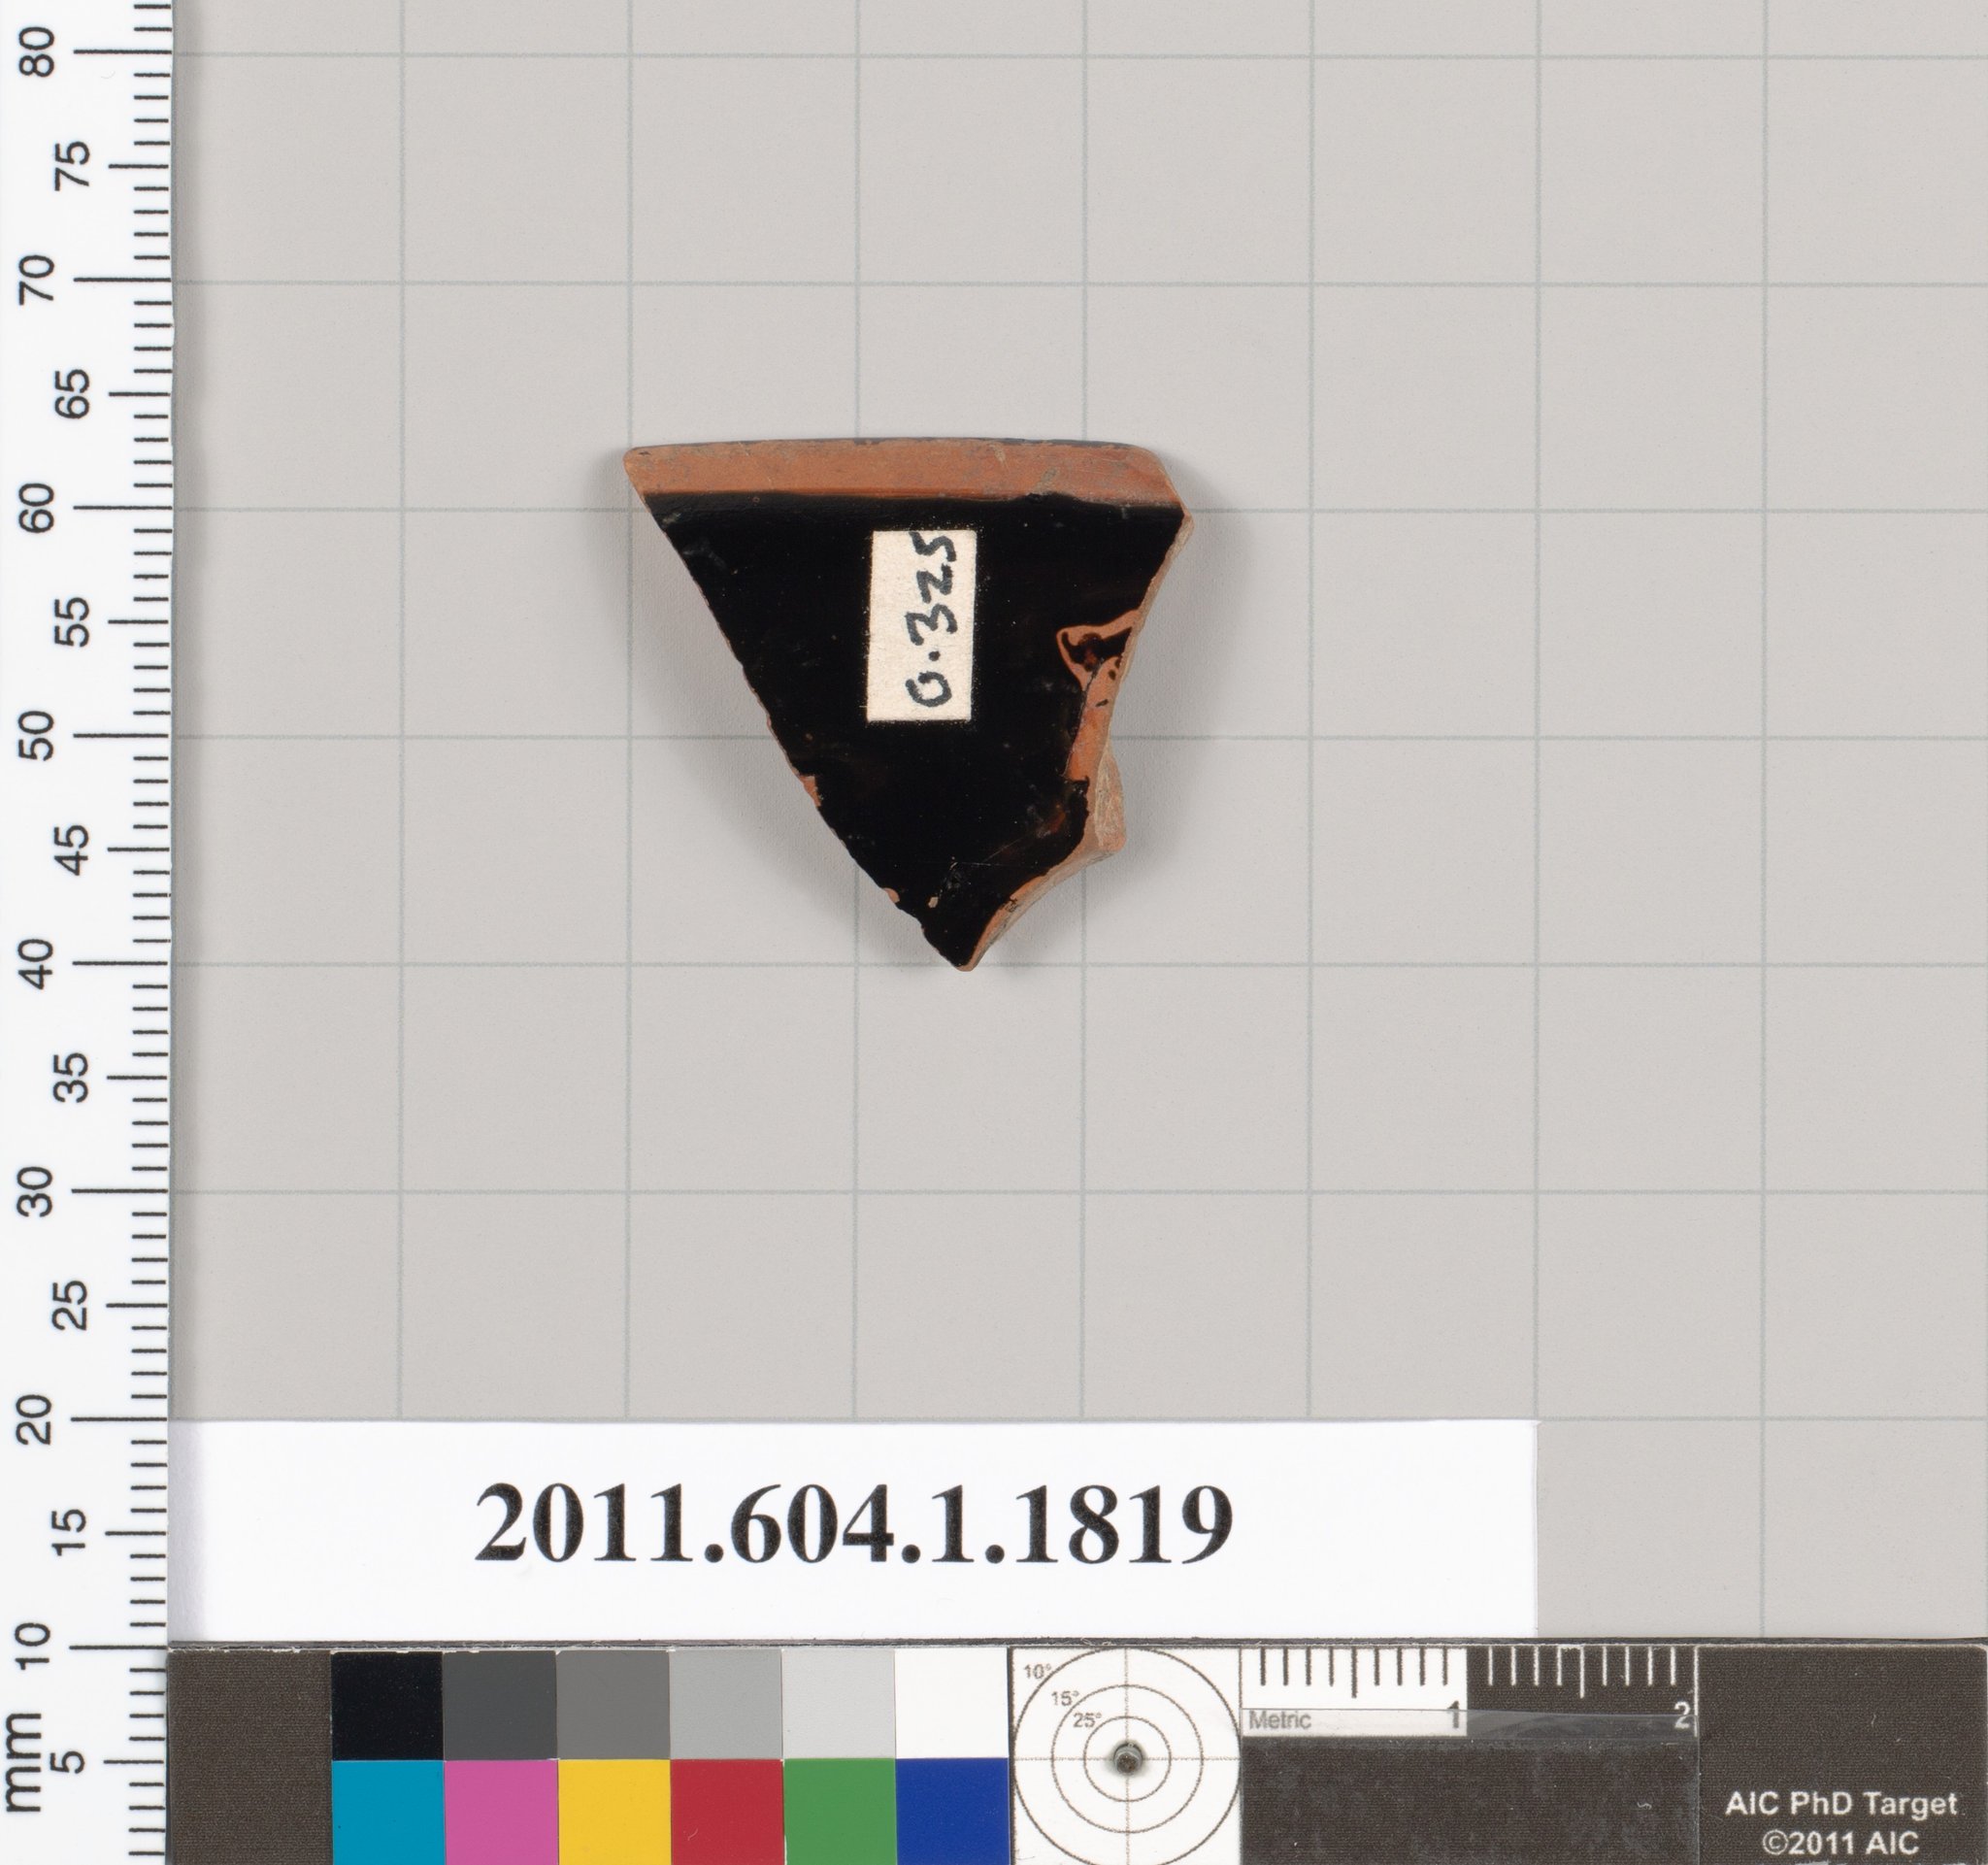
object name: kylix fragment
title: Terracotta rim fragment of a kylix (drinking cup)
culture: greek, attic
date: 467-435 BCE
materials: terracotta